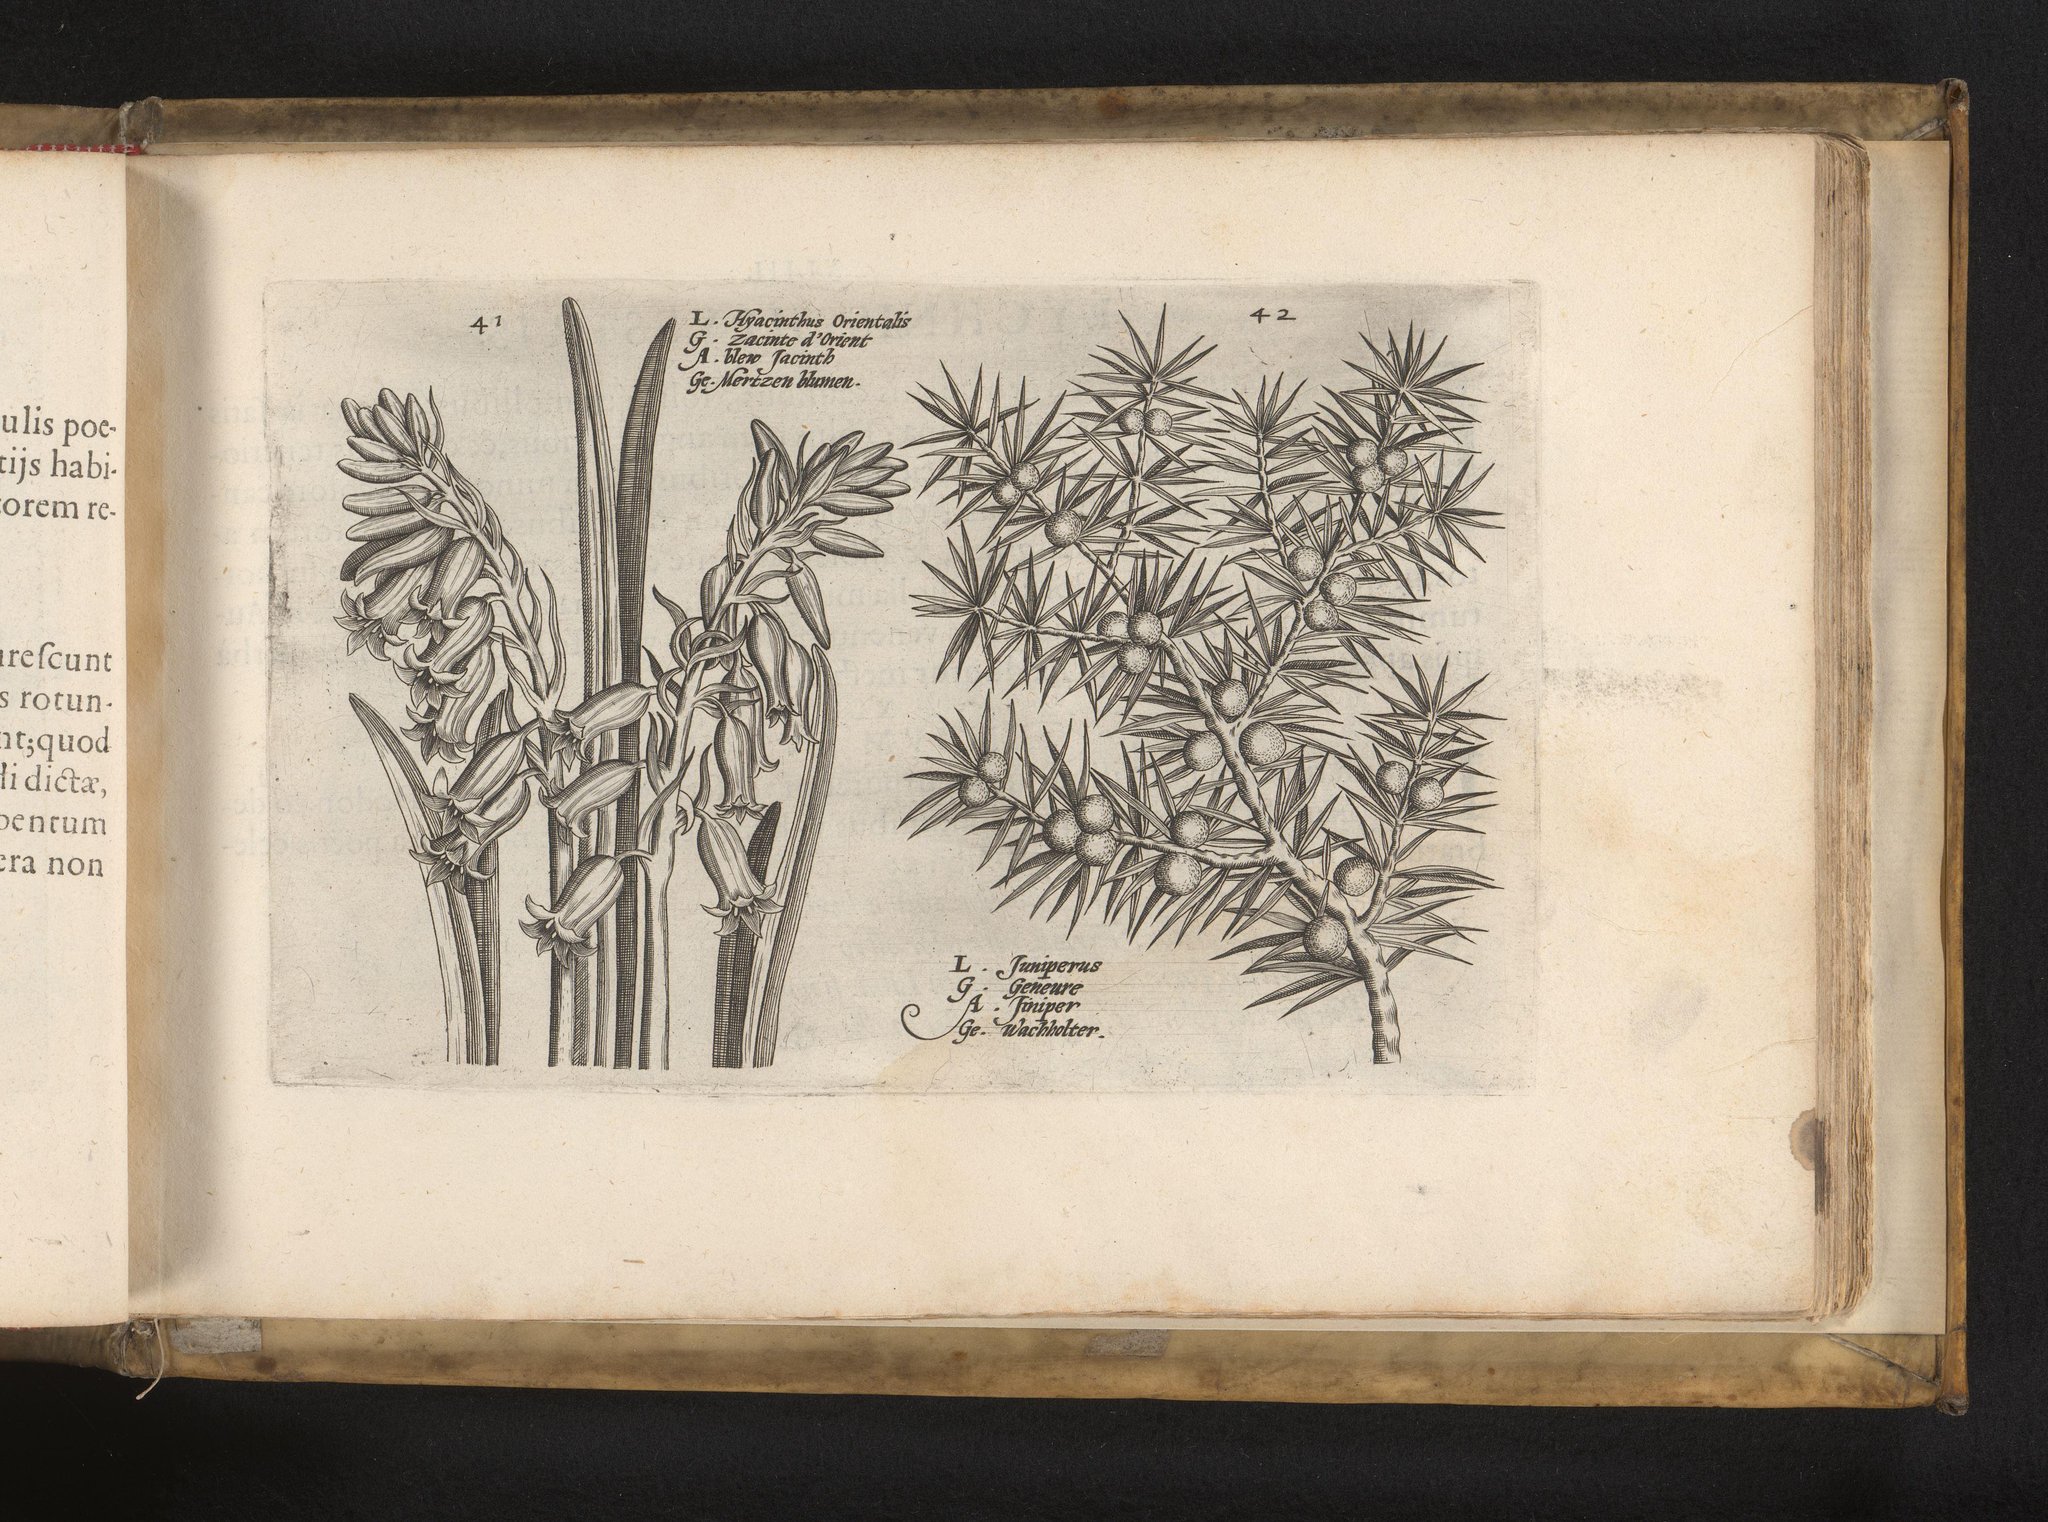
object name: book illustration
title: Juniperus / Genevre / Juniper / Wachholter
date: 1617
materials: paper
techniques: engraving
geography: arnhem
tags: flowers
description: Prent uit: Passe, Crispijn van de (II). Hortus floridus in quo rariorum & minus vulgarium florum icones ad vivam veramque formam. Arnhem: Johannes Janssonius, 1617.